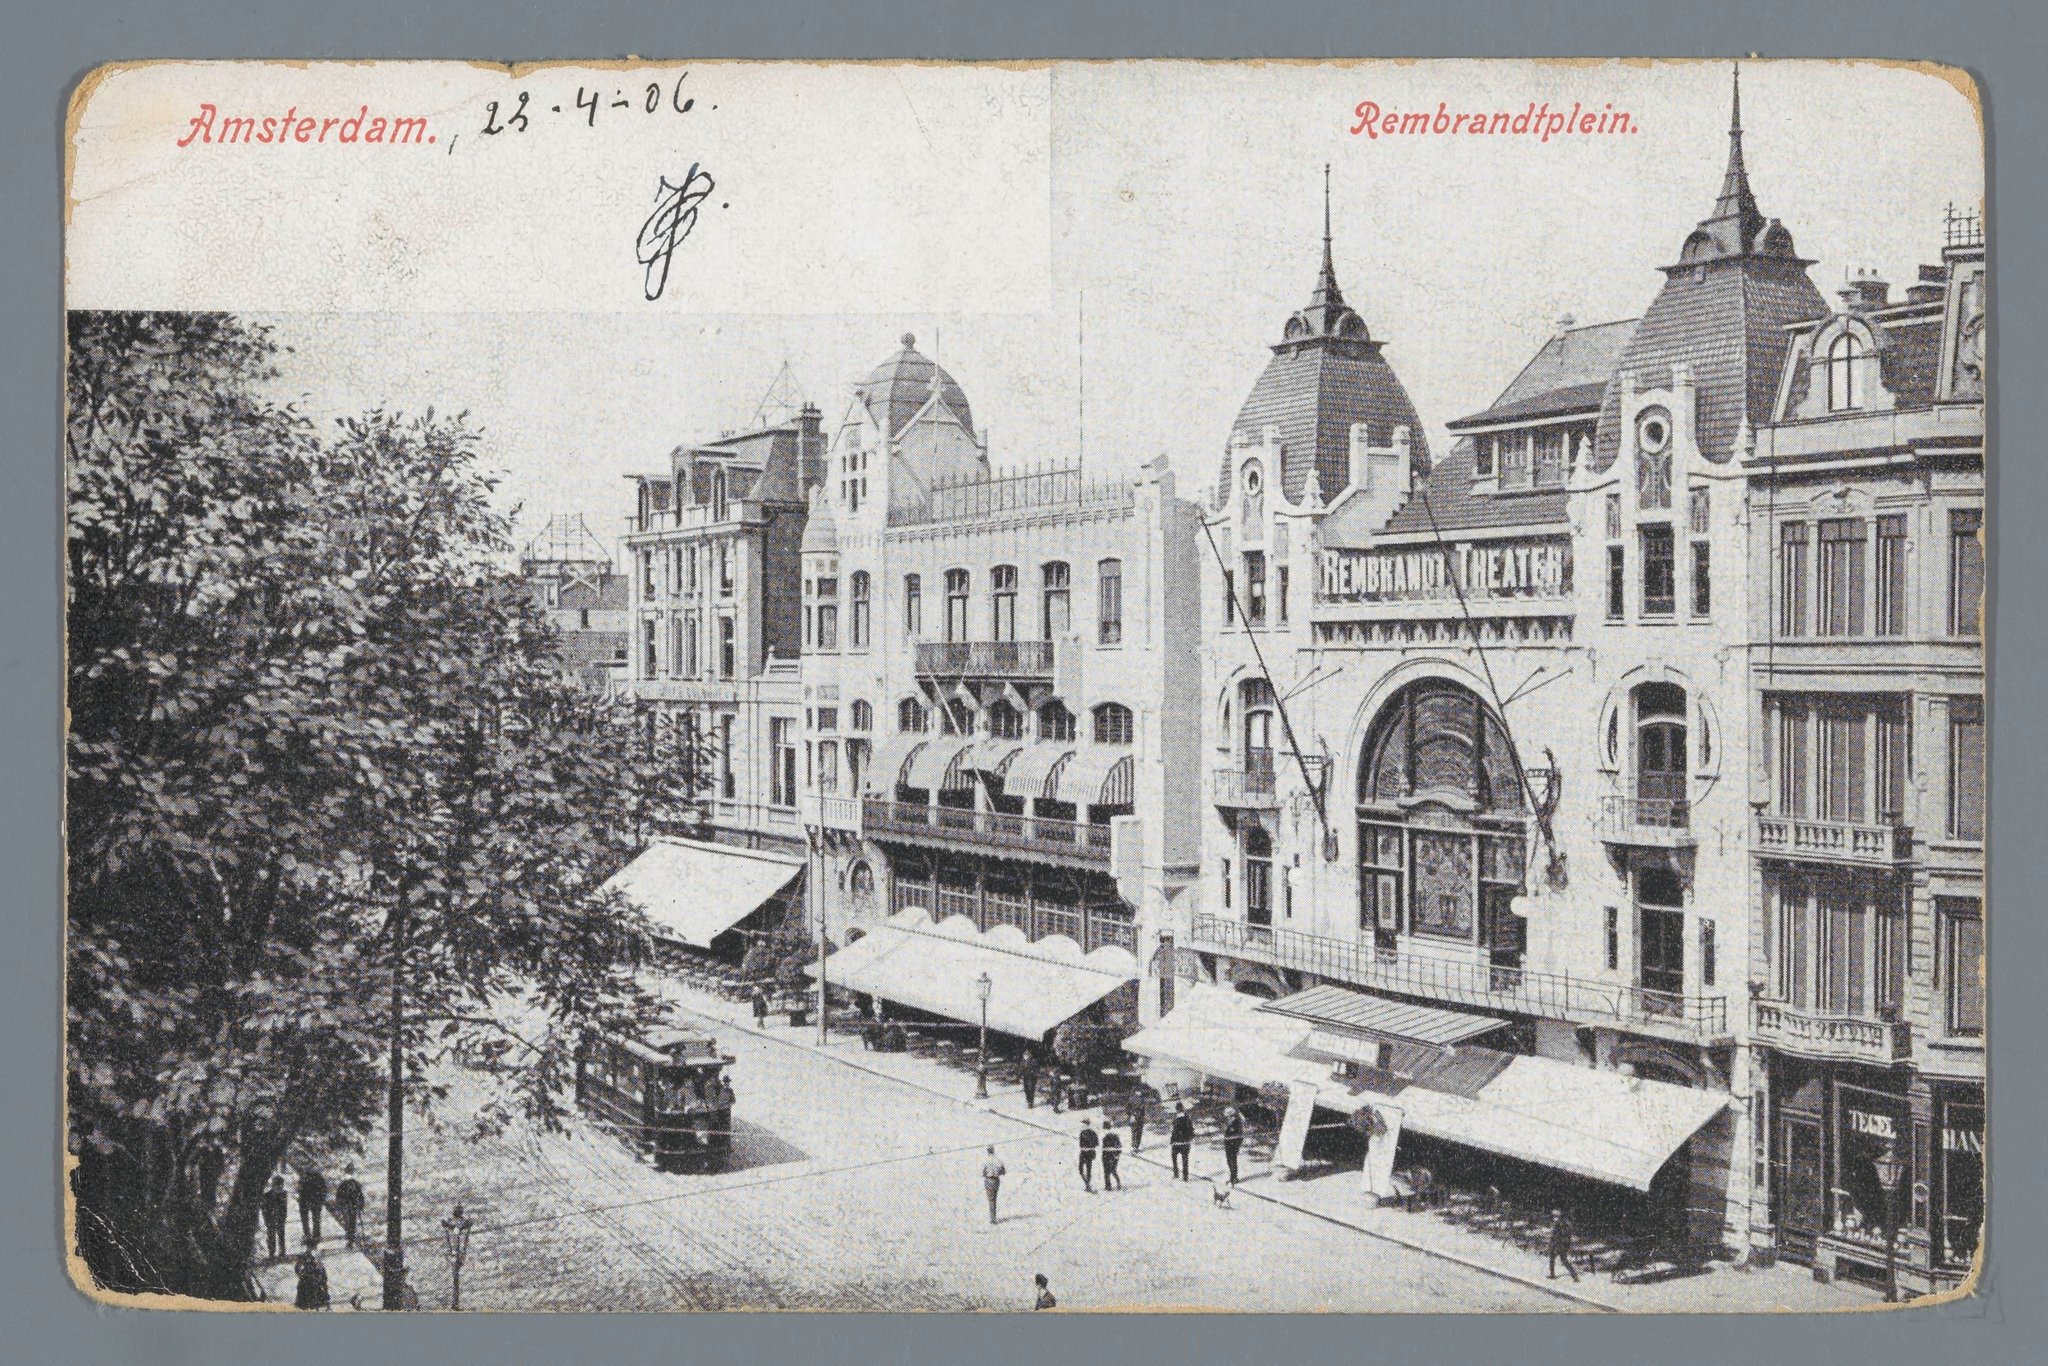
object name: photomechanical print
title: Amsterdam, Rembrandtplein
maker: h.s. speelman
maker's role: publisher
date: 1906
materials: cardboard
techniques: writing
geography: the hague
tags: square, place, circus, etc.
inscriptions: number: ‘448’